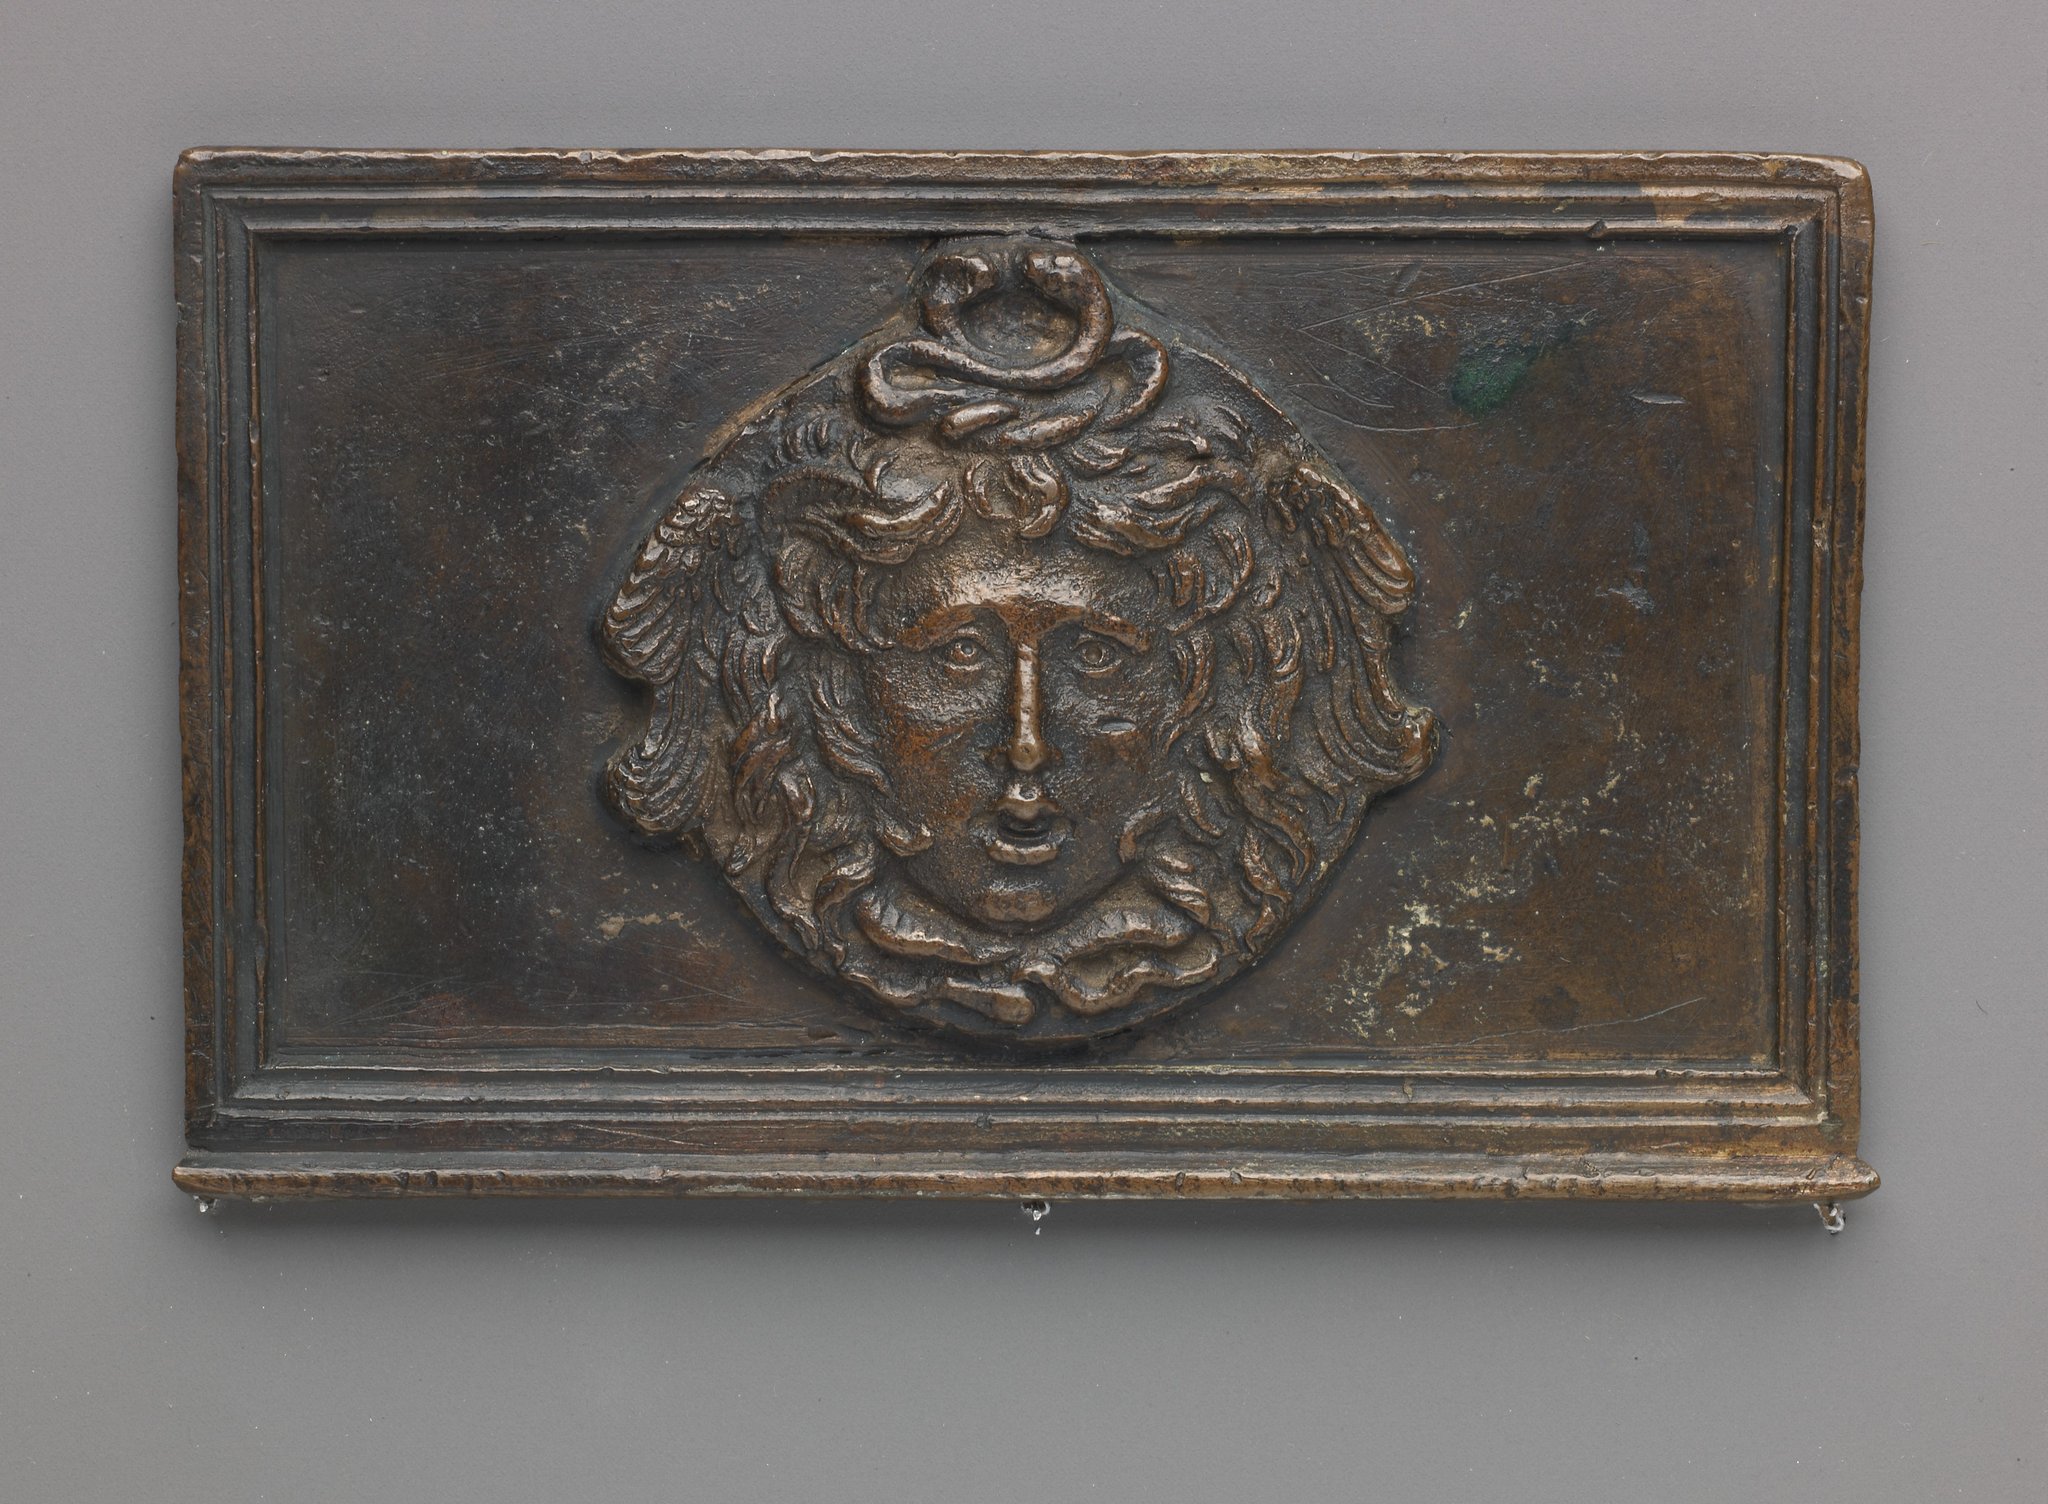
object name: plaquette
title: Side panel of a writing box (decorated with Medusa mask)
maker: severo calzetta da ravenna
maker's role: artist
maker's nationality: italian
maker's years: 1496-1543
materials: copper alloy, patina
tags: medusa